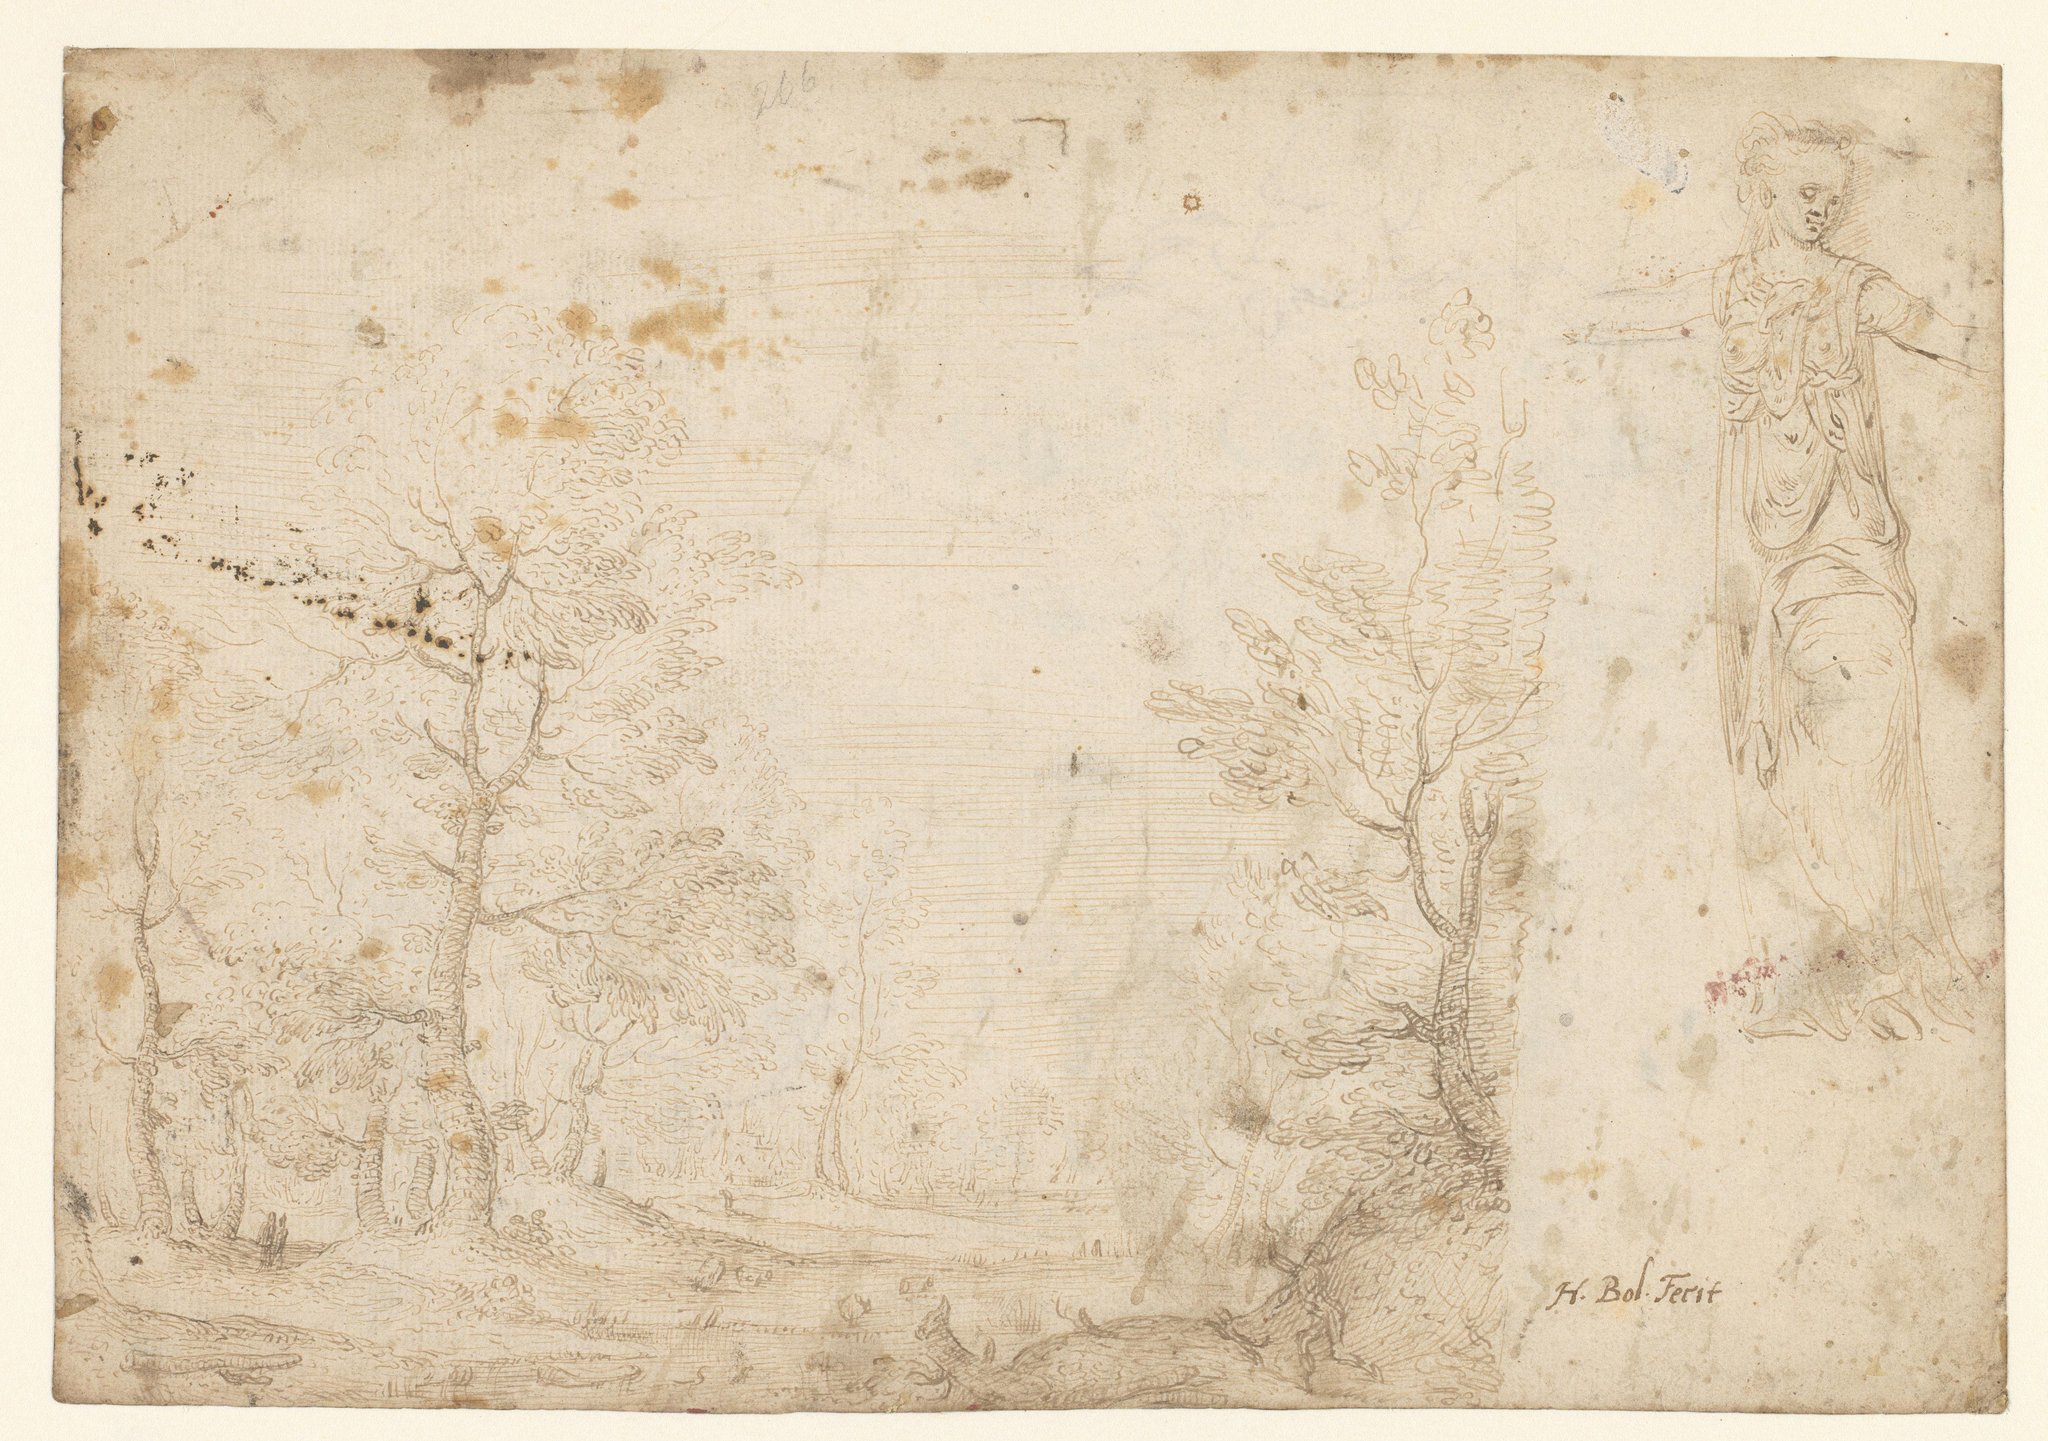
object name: drawing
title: Weide en een standbeeld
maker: hans bol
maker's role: draughtsman, print maker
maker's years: 1534-1593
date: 1560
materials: ink, paper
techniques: pen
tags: river, monument, statue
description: Weide tussen hoge bomen en rechts een studie van een standbeeld van een vrouwelijk figuur.